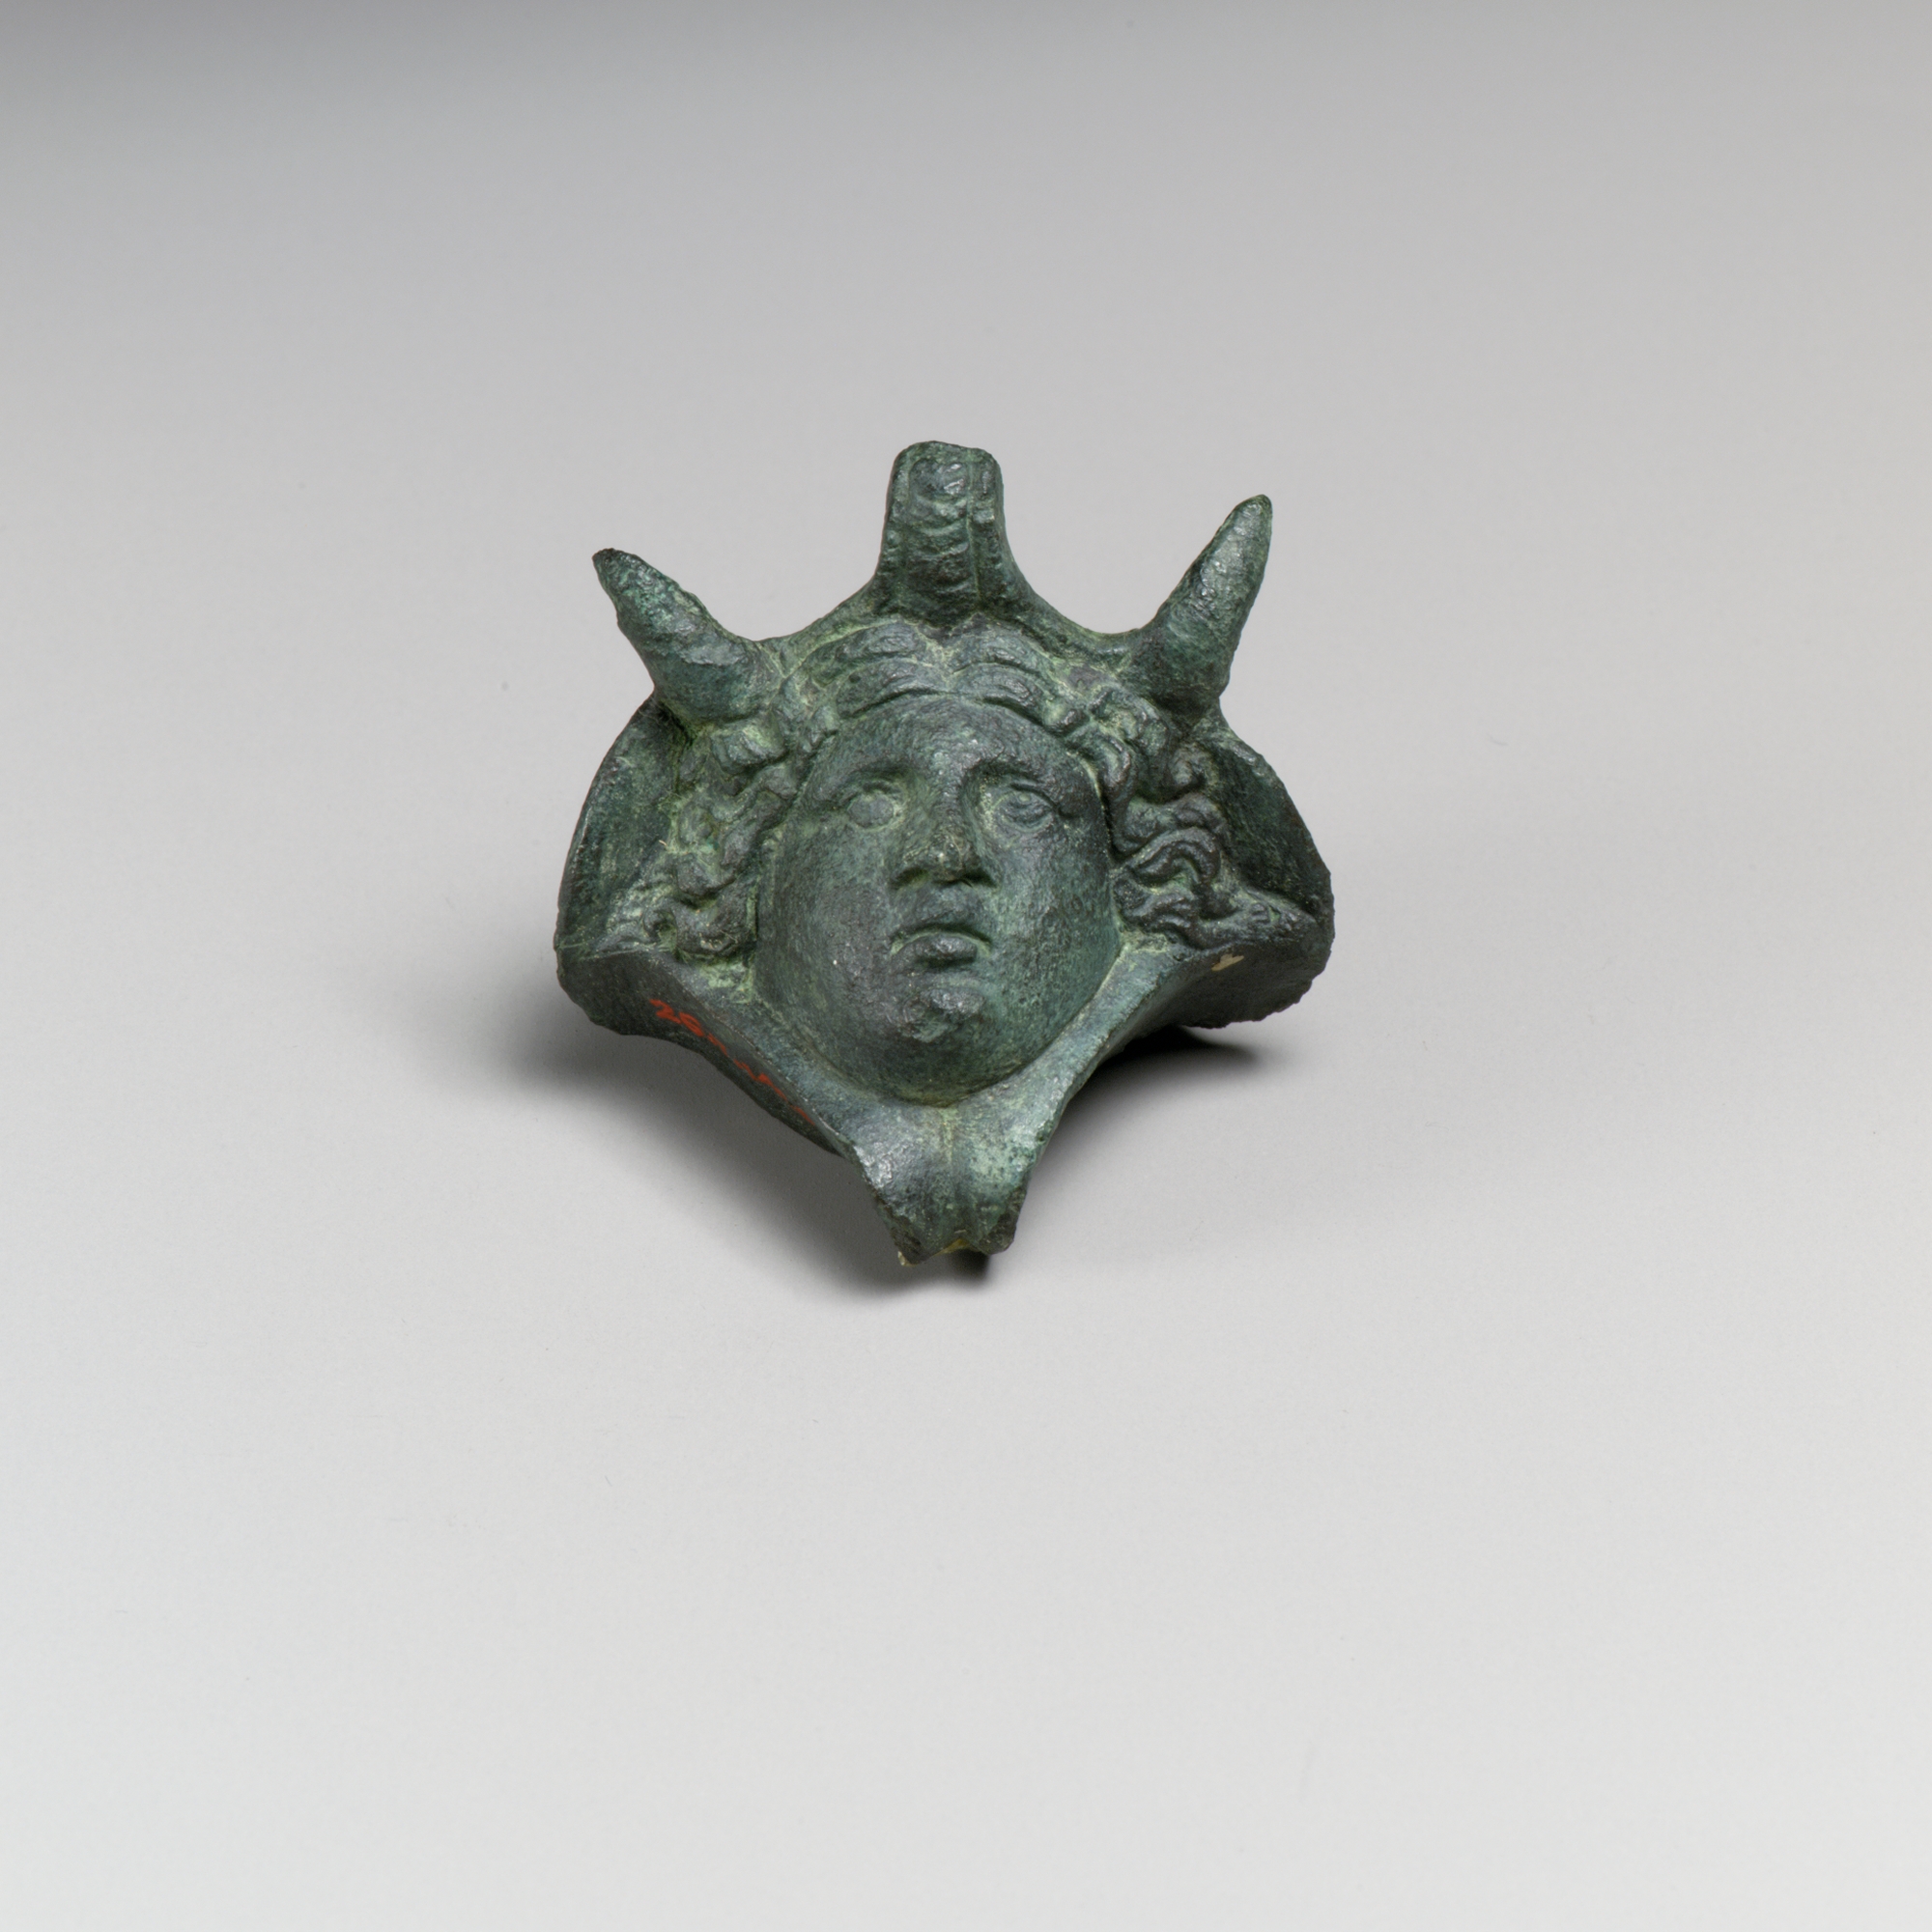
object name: head, elephant headdress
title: Decorative attachment in the form of a head wearing an elephant headdress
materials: bronze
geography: egypt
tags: heads